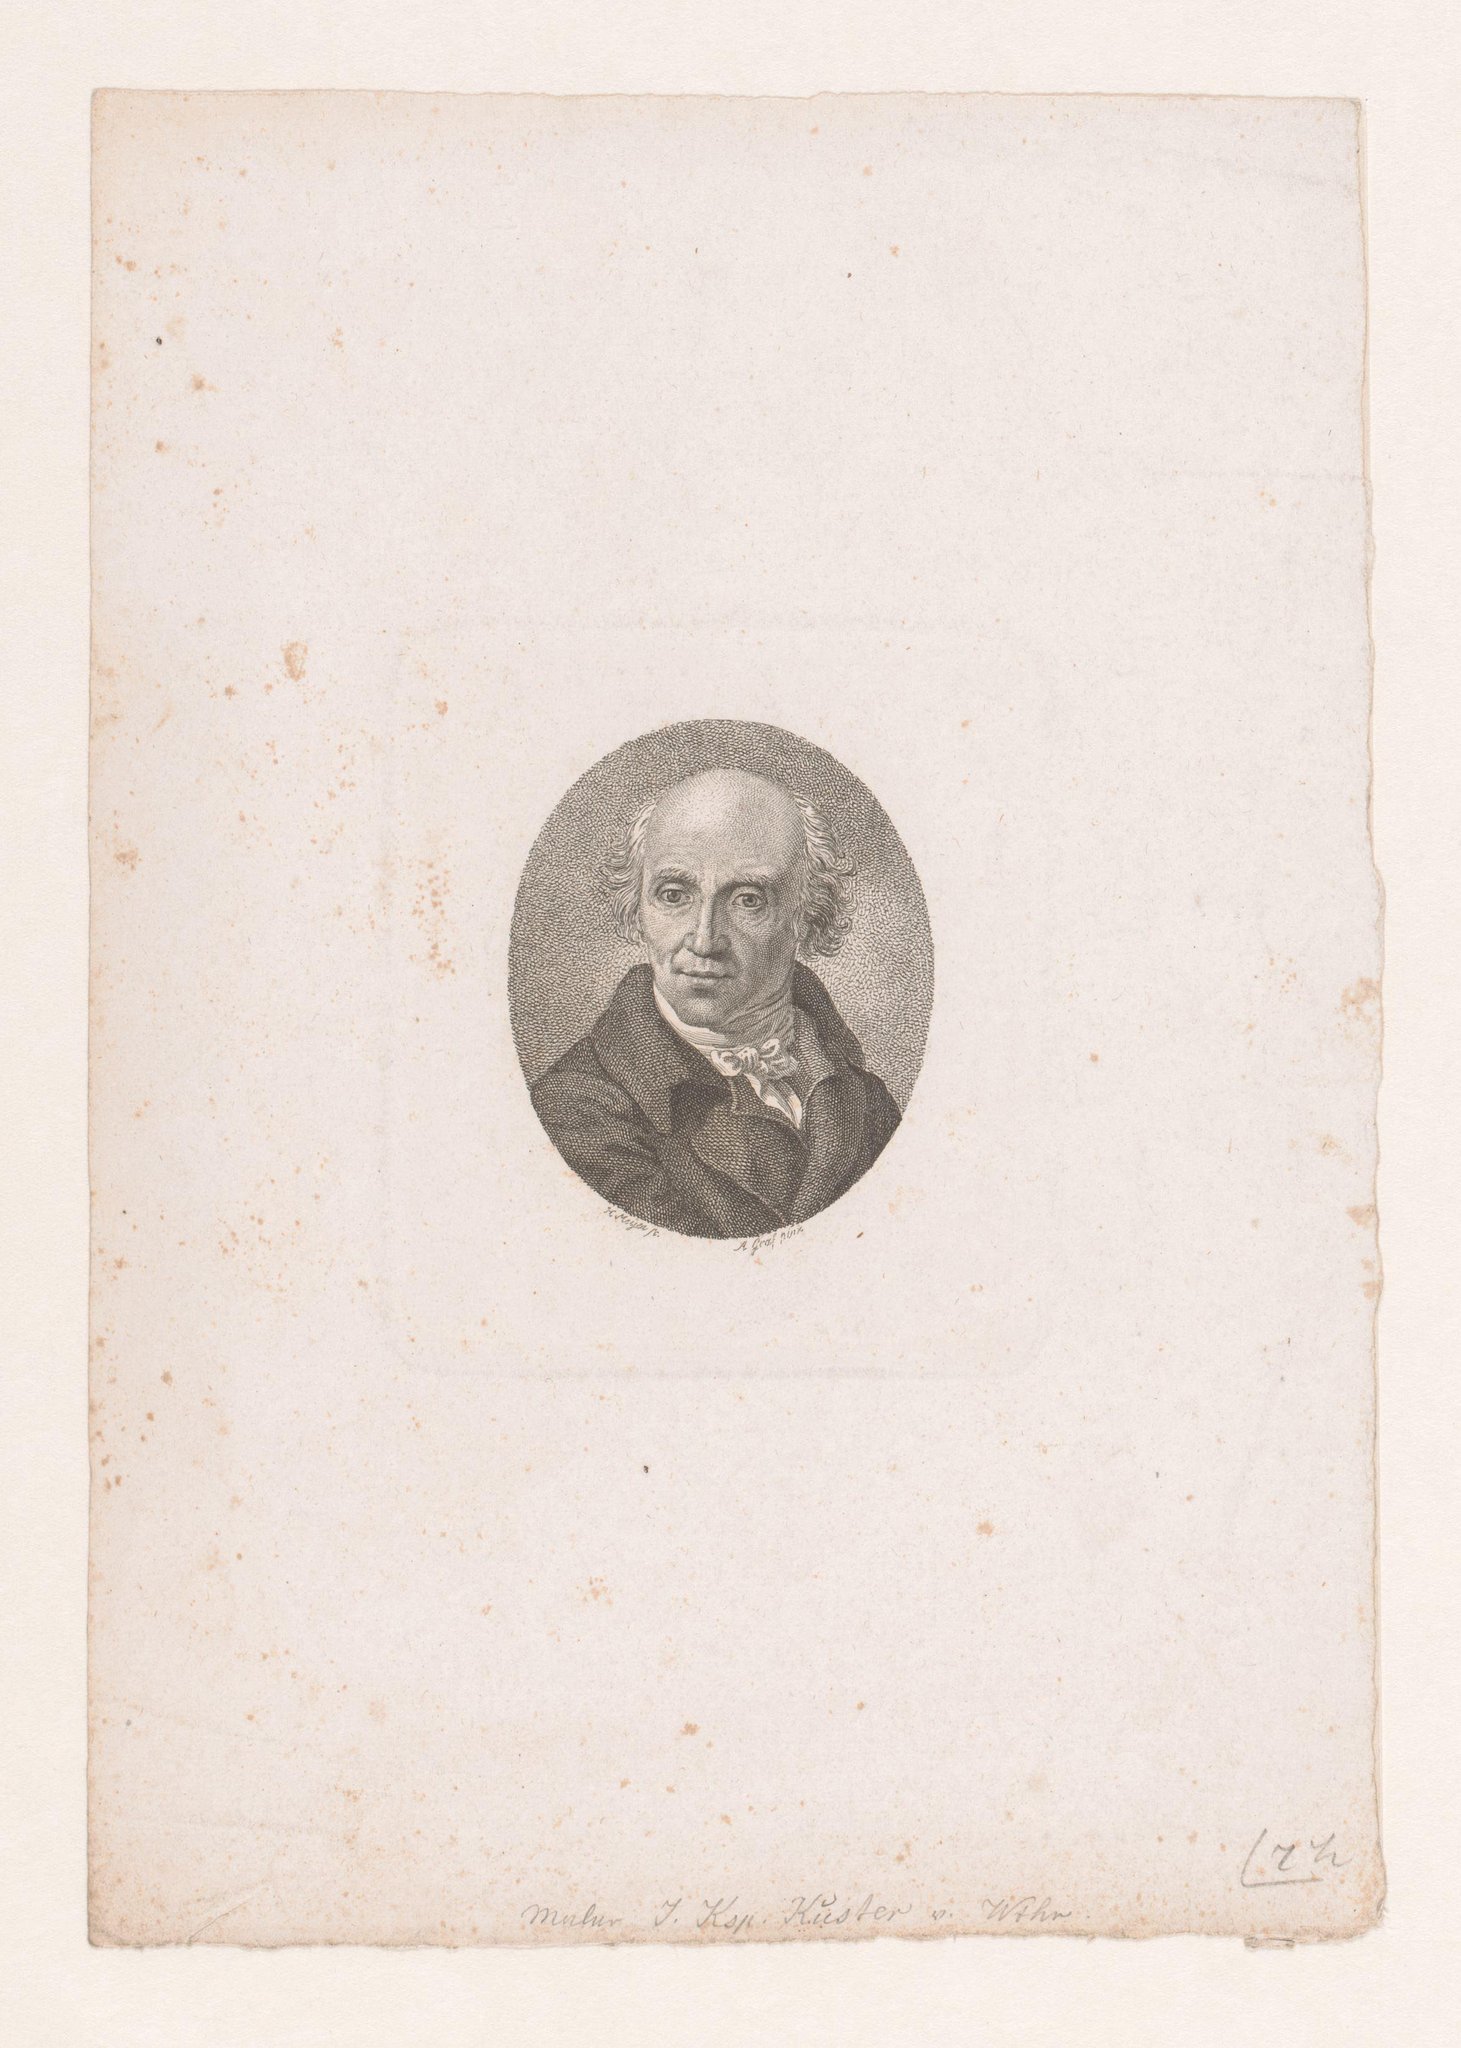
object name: print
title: Portret van Johann Kaspar Küster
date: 1812-1877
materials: paper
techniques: etching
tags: painter, historical persons, portrait, self-portrait of painter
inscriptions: collector's mark: Lugt 2228